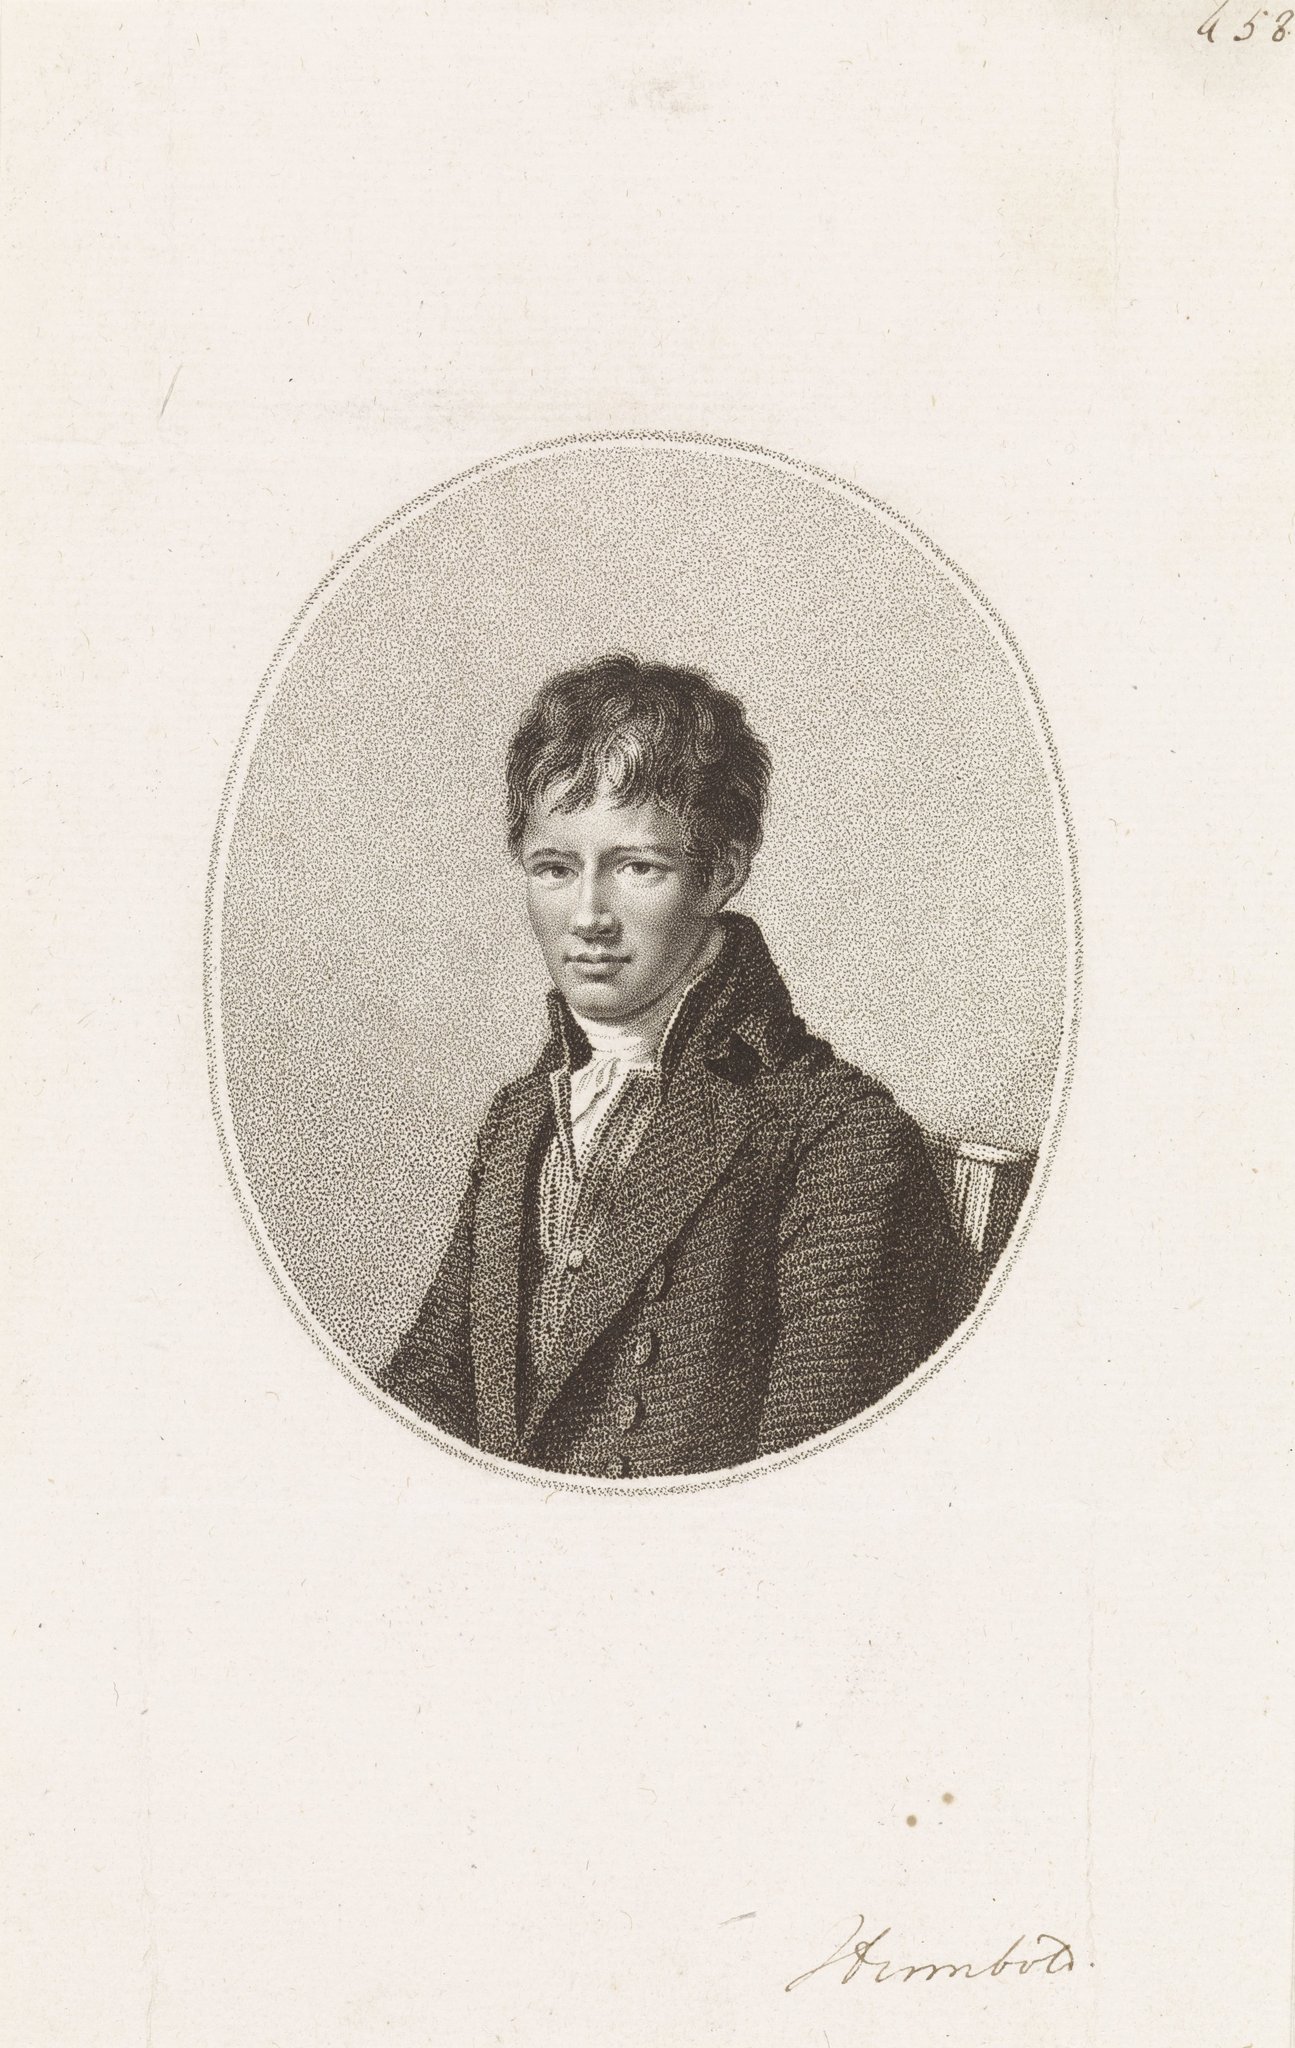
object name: print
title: Portret van de Duitse wetenschapper Alexander von Humboldt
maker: ludwig gottlieb portman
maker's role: print maker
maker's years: 1772-1828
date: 1787-1828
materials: paper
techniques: stippled etching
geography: amsterdam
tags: berlin, traveler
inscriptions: inscription: ‘Humbol.’, number: ‘458.’, collector's mark: Lugt 2228